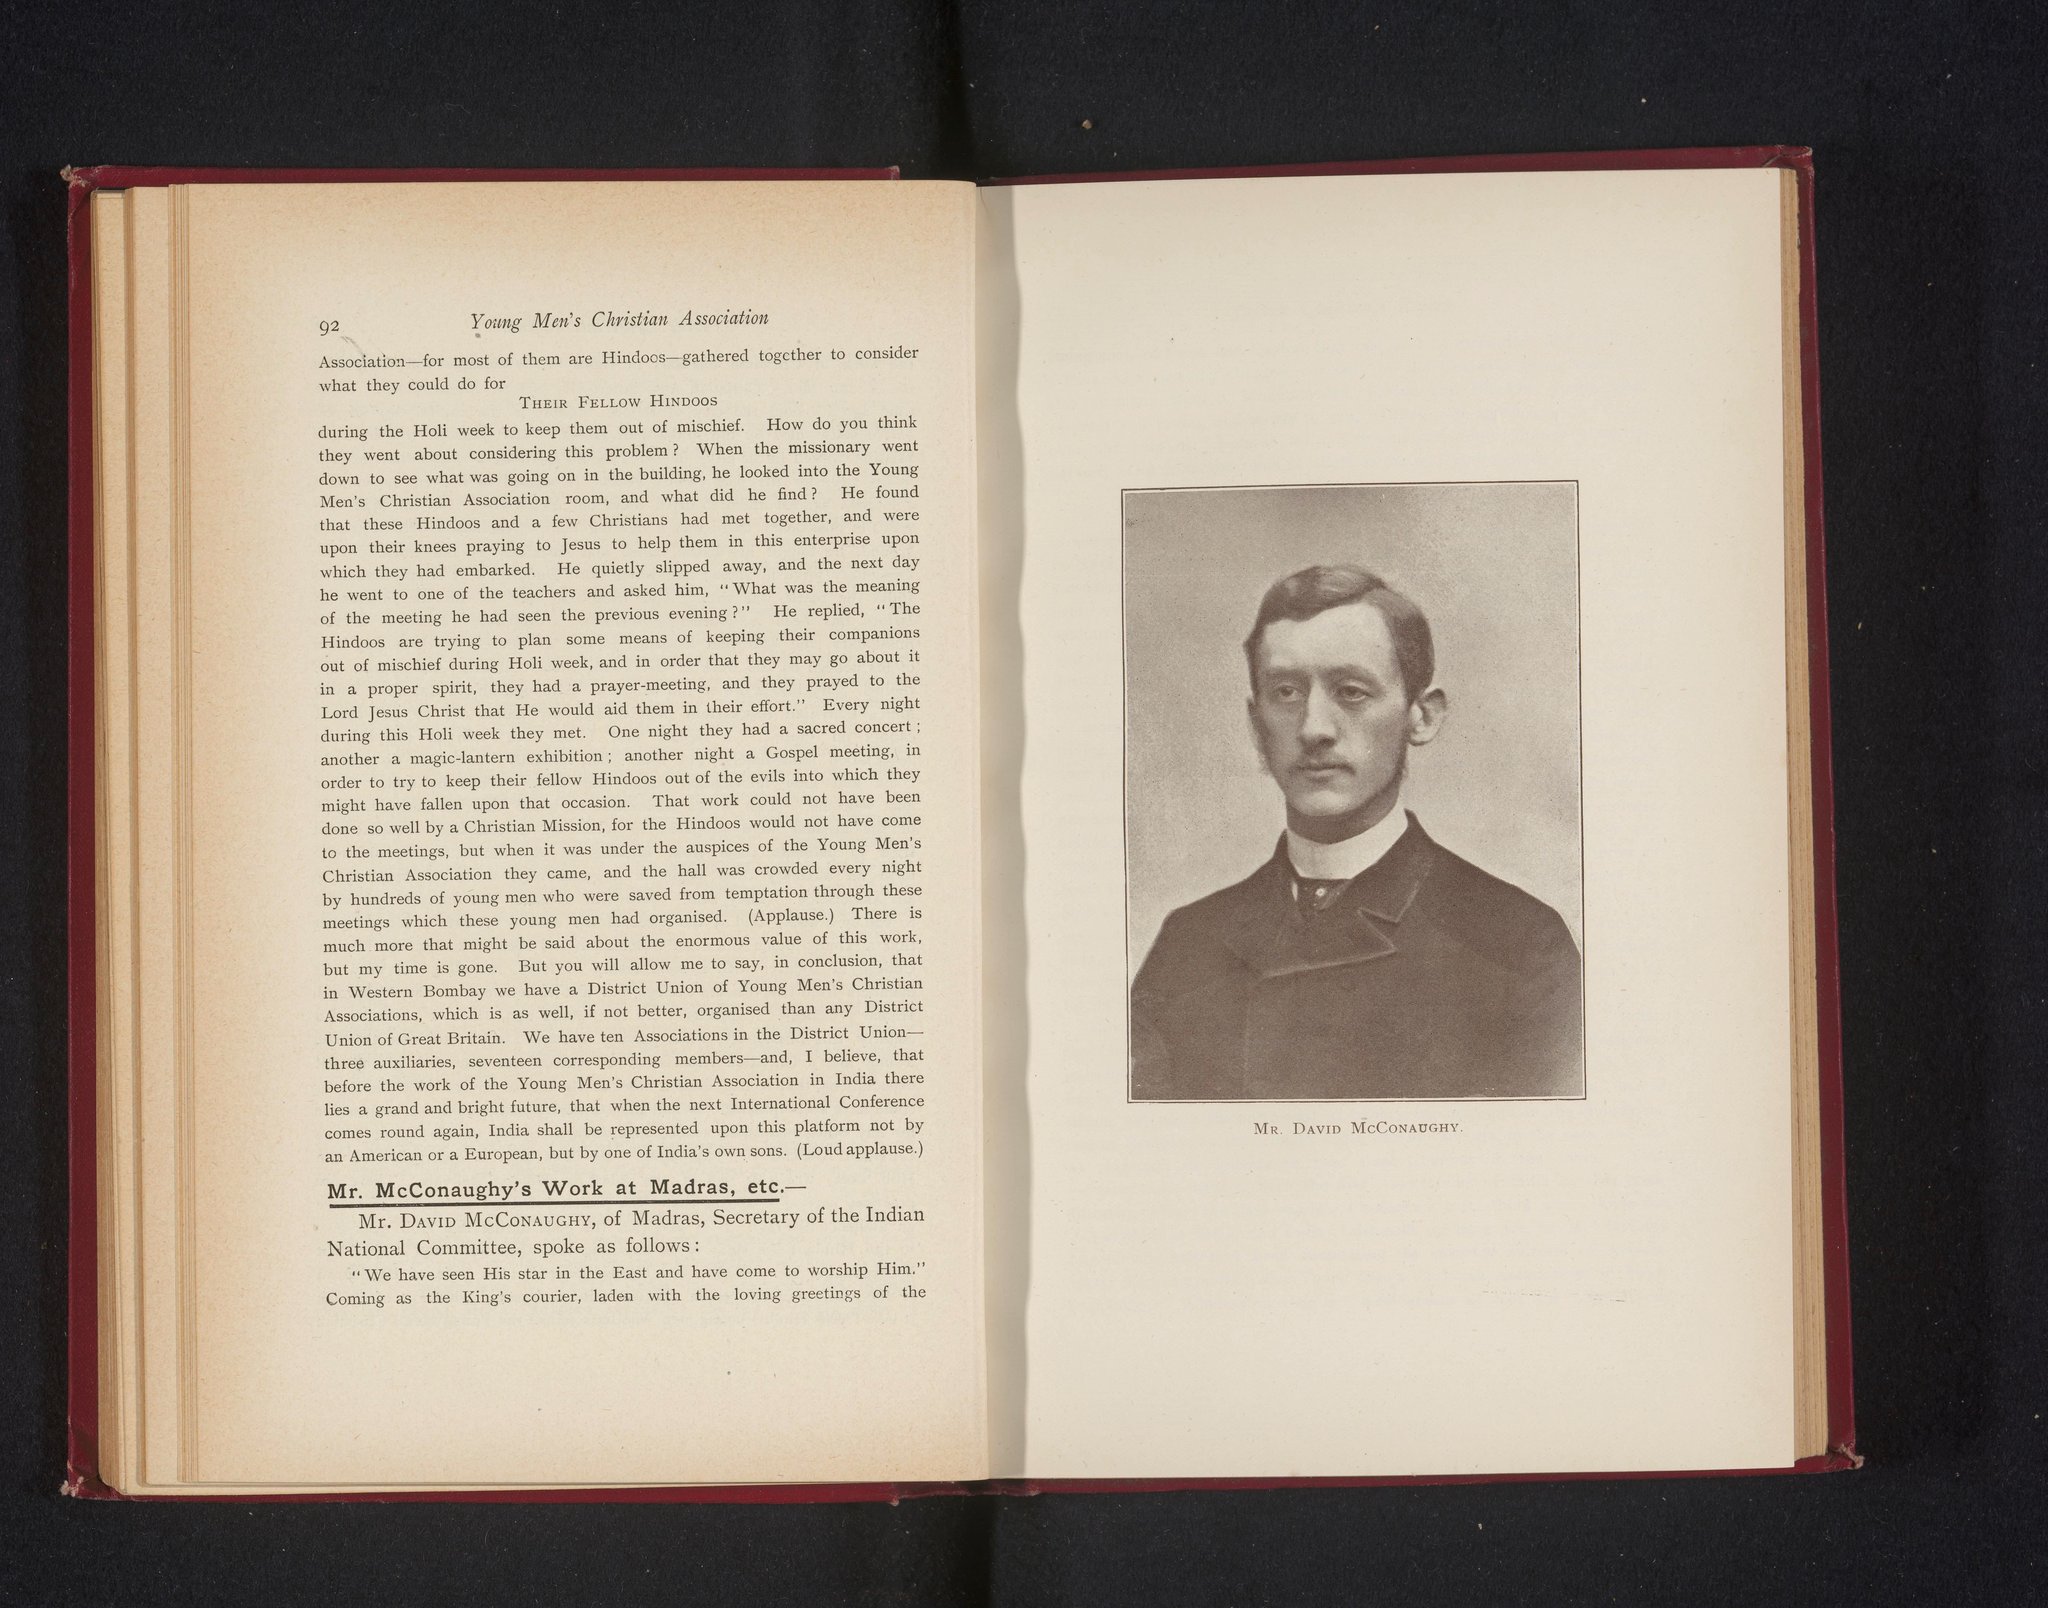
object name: page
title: Portret van David McConaughy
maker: Anonymous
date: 1890-1895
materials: paper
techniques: autotype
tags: historical persons